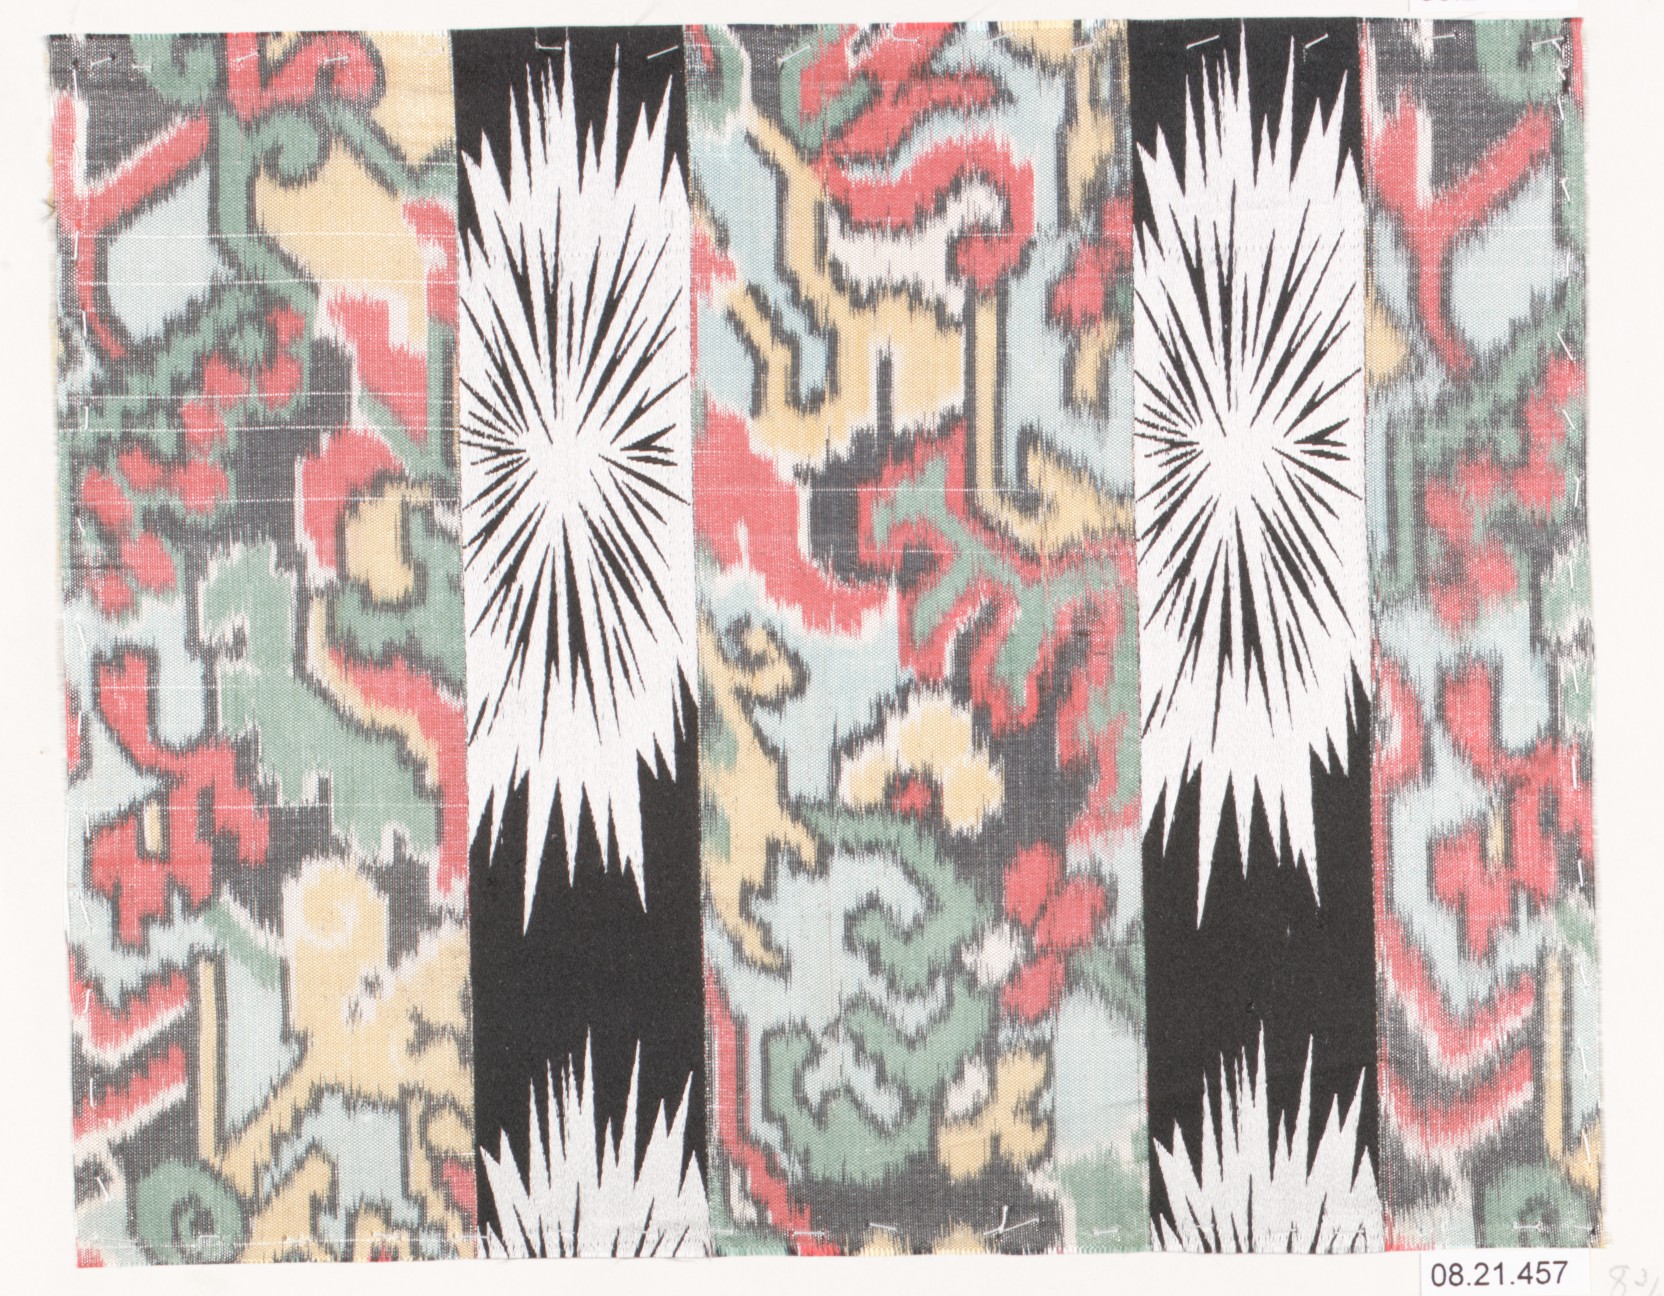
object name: textile sample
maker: Anonymous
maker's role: designer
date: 1900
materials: silk